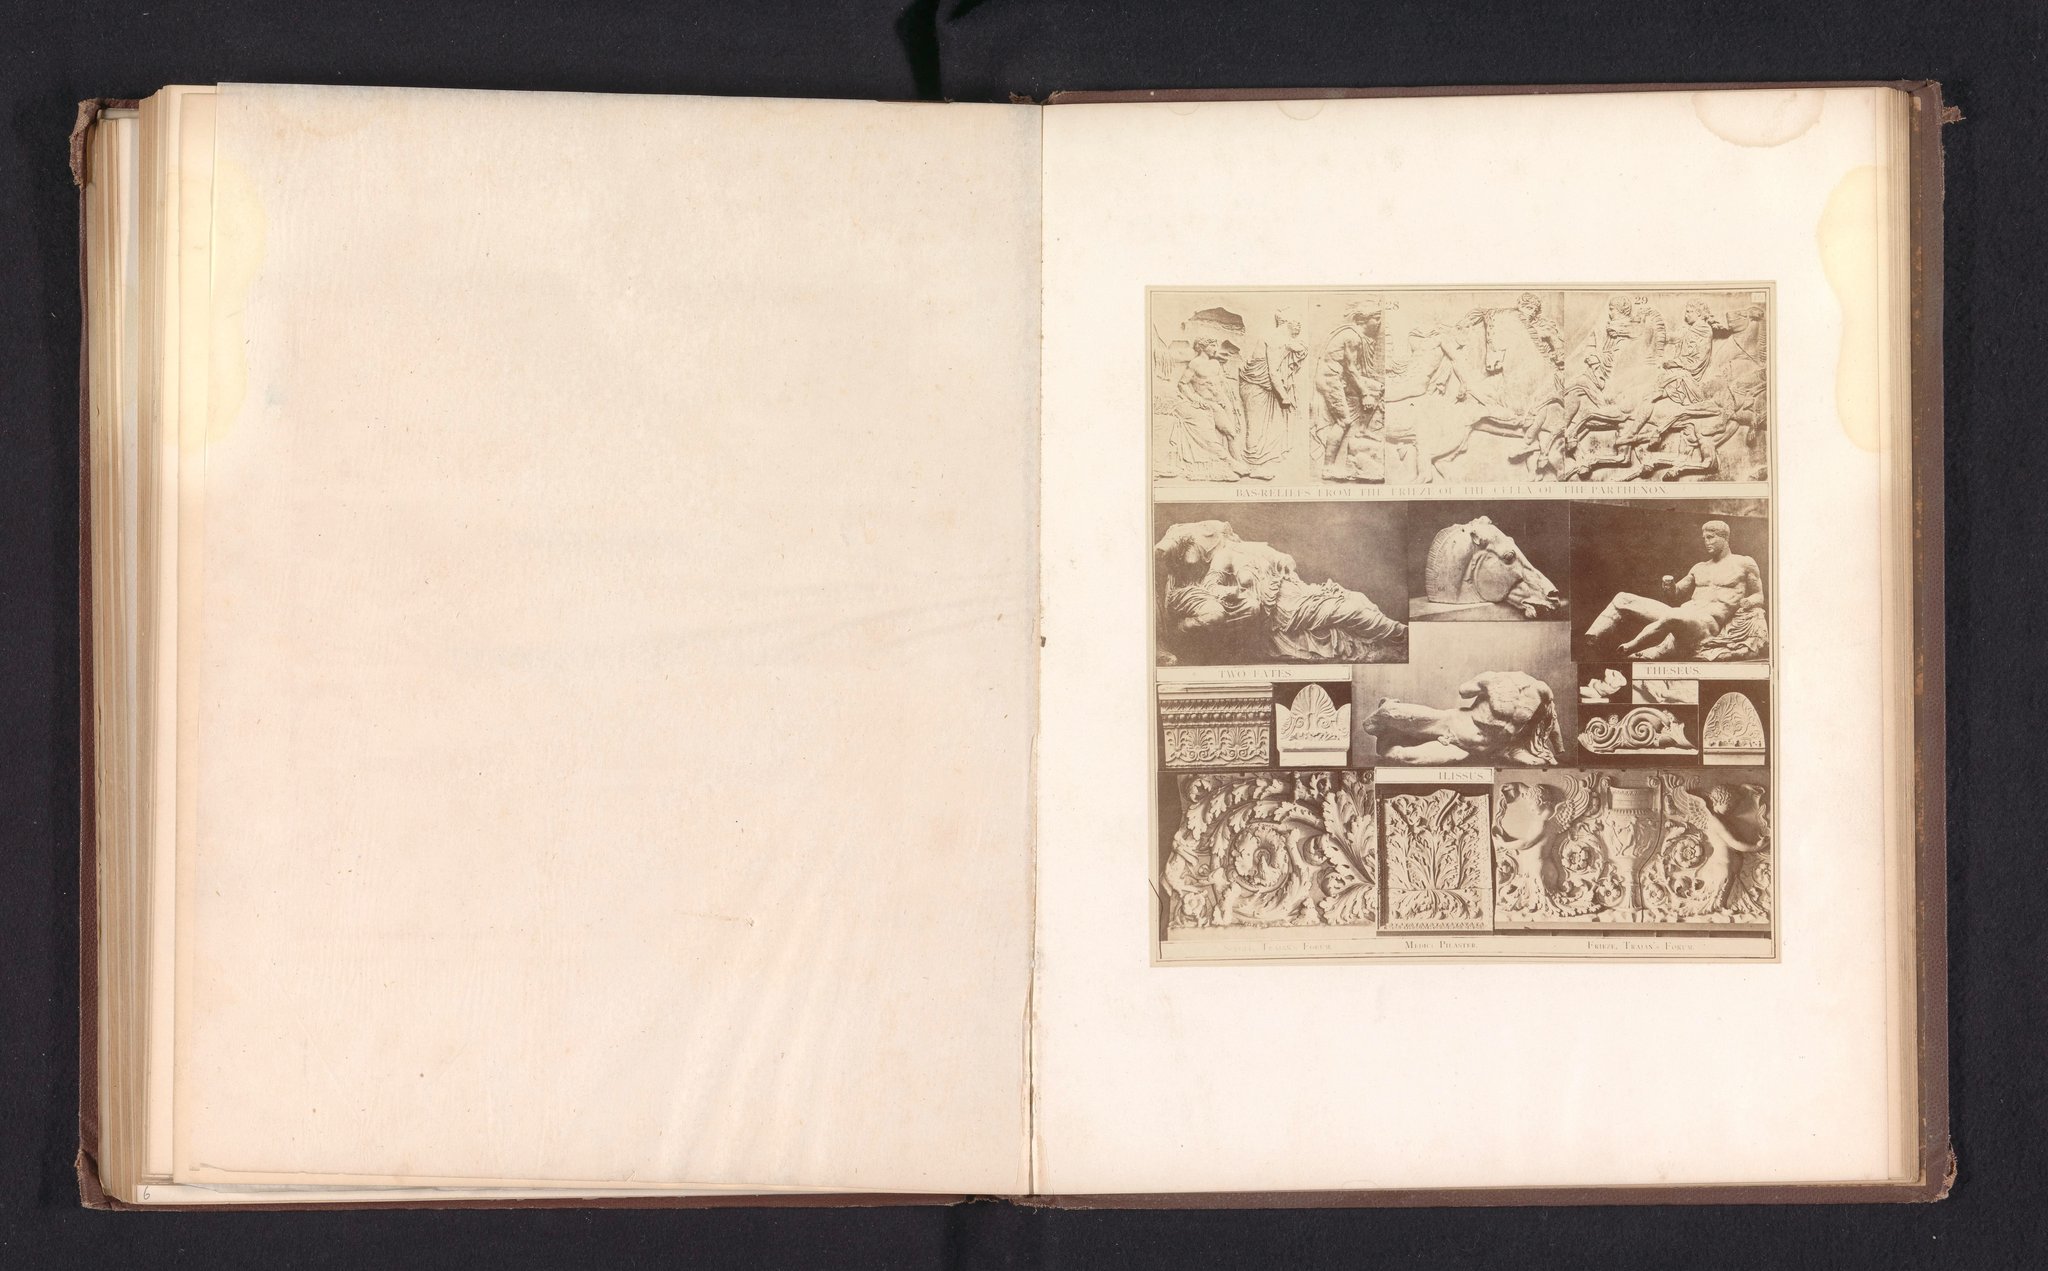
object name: page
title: Afgietsels van antieke sculpturen en bouwfragmenten waaronder een stuk van het fries van het Parthenon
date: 1864-1874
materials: photographic support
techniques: albumen print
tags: stylistic and formal differentiation of art, piece of sculpture, reproduction of a piece of sculpture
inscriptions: inscription: ‘Bas Relief from the Frieze of the Cella of the Parthenon Two Eates Theseus Ilissus (...)’